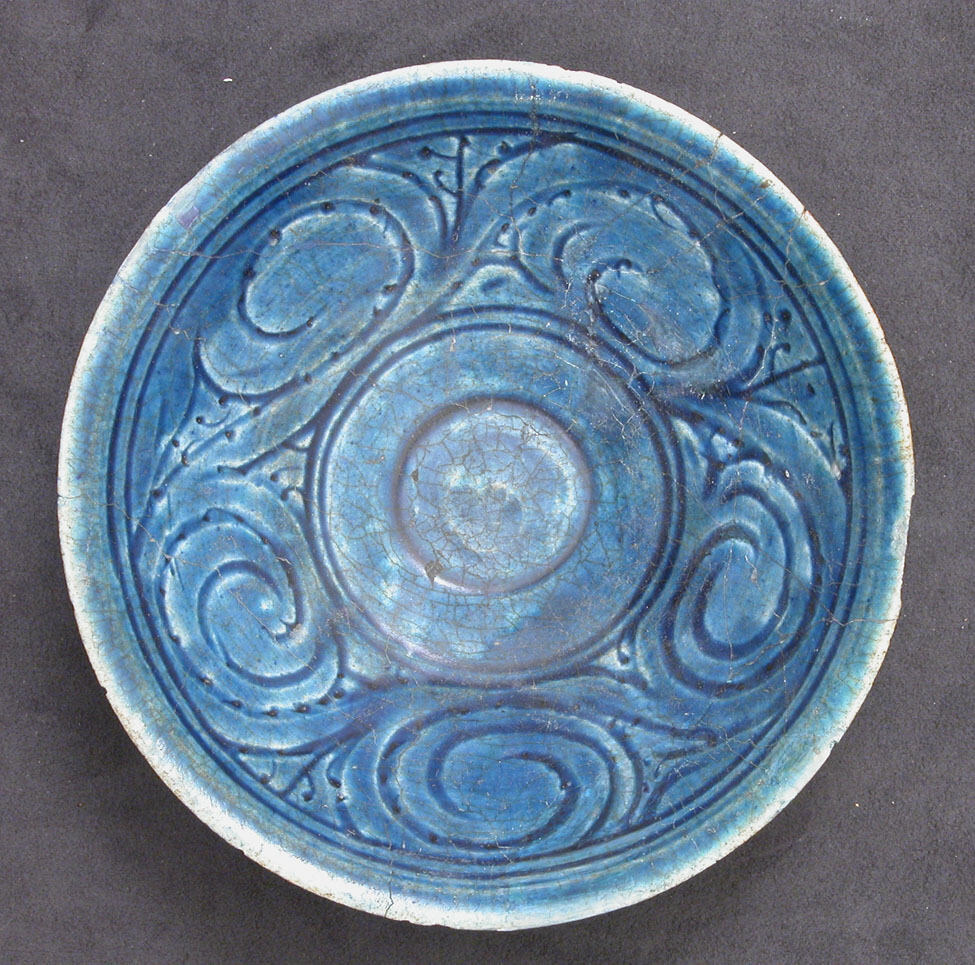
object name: bowl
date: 1101-1300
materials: stonepaste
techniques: glazing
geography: iran